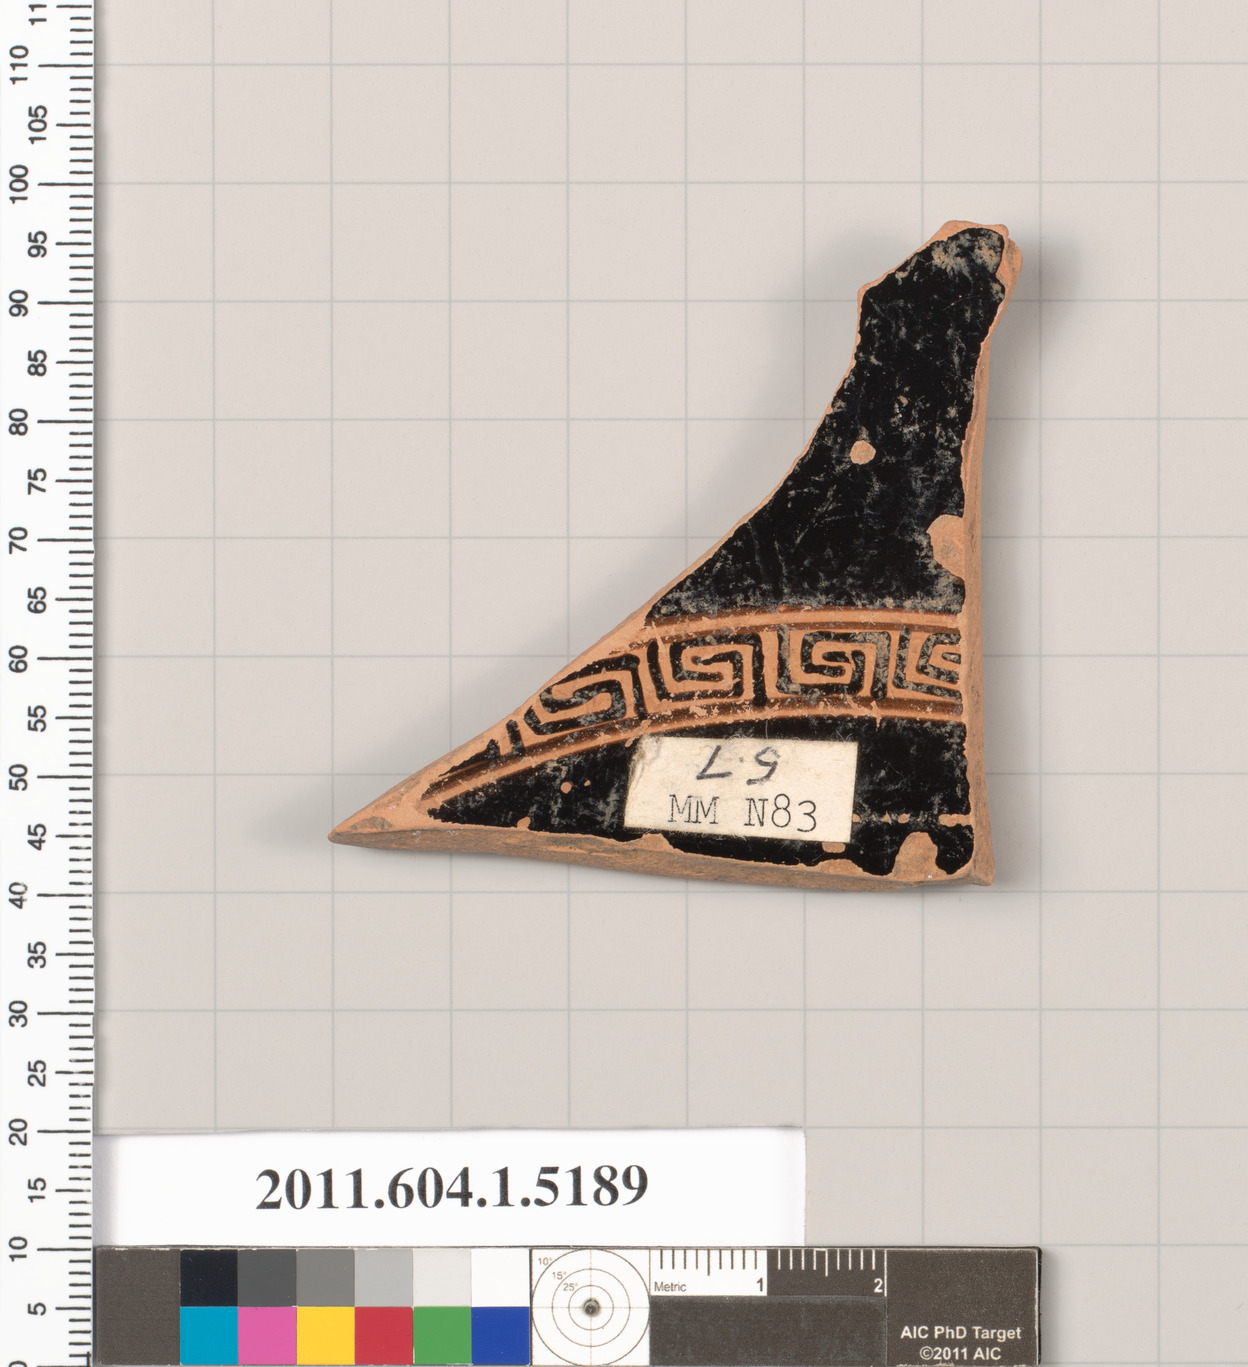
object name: kylix fragment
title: Terracotta fragment of a kylix (drinking cup)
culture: greek, attic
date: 520-500 BCE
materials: terracotta